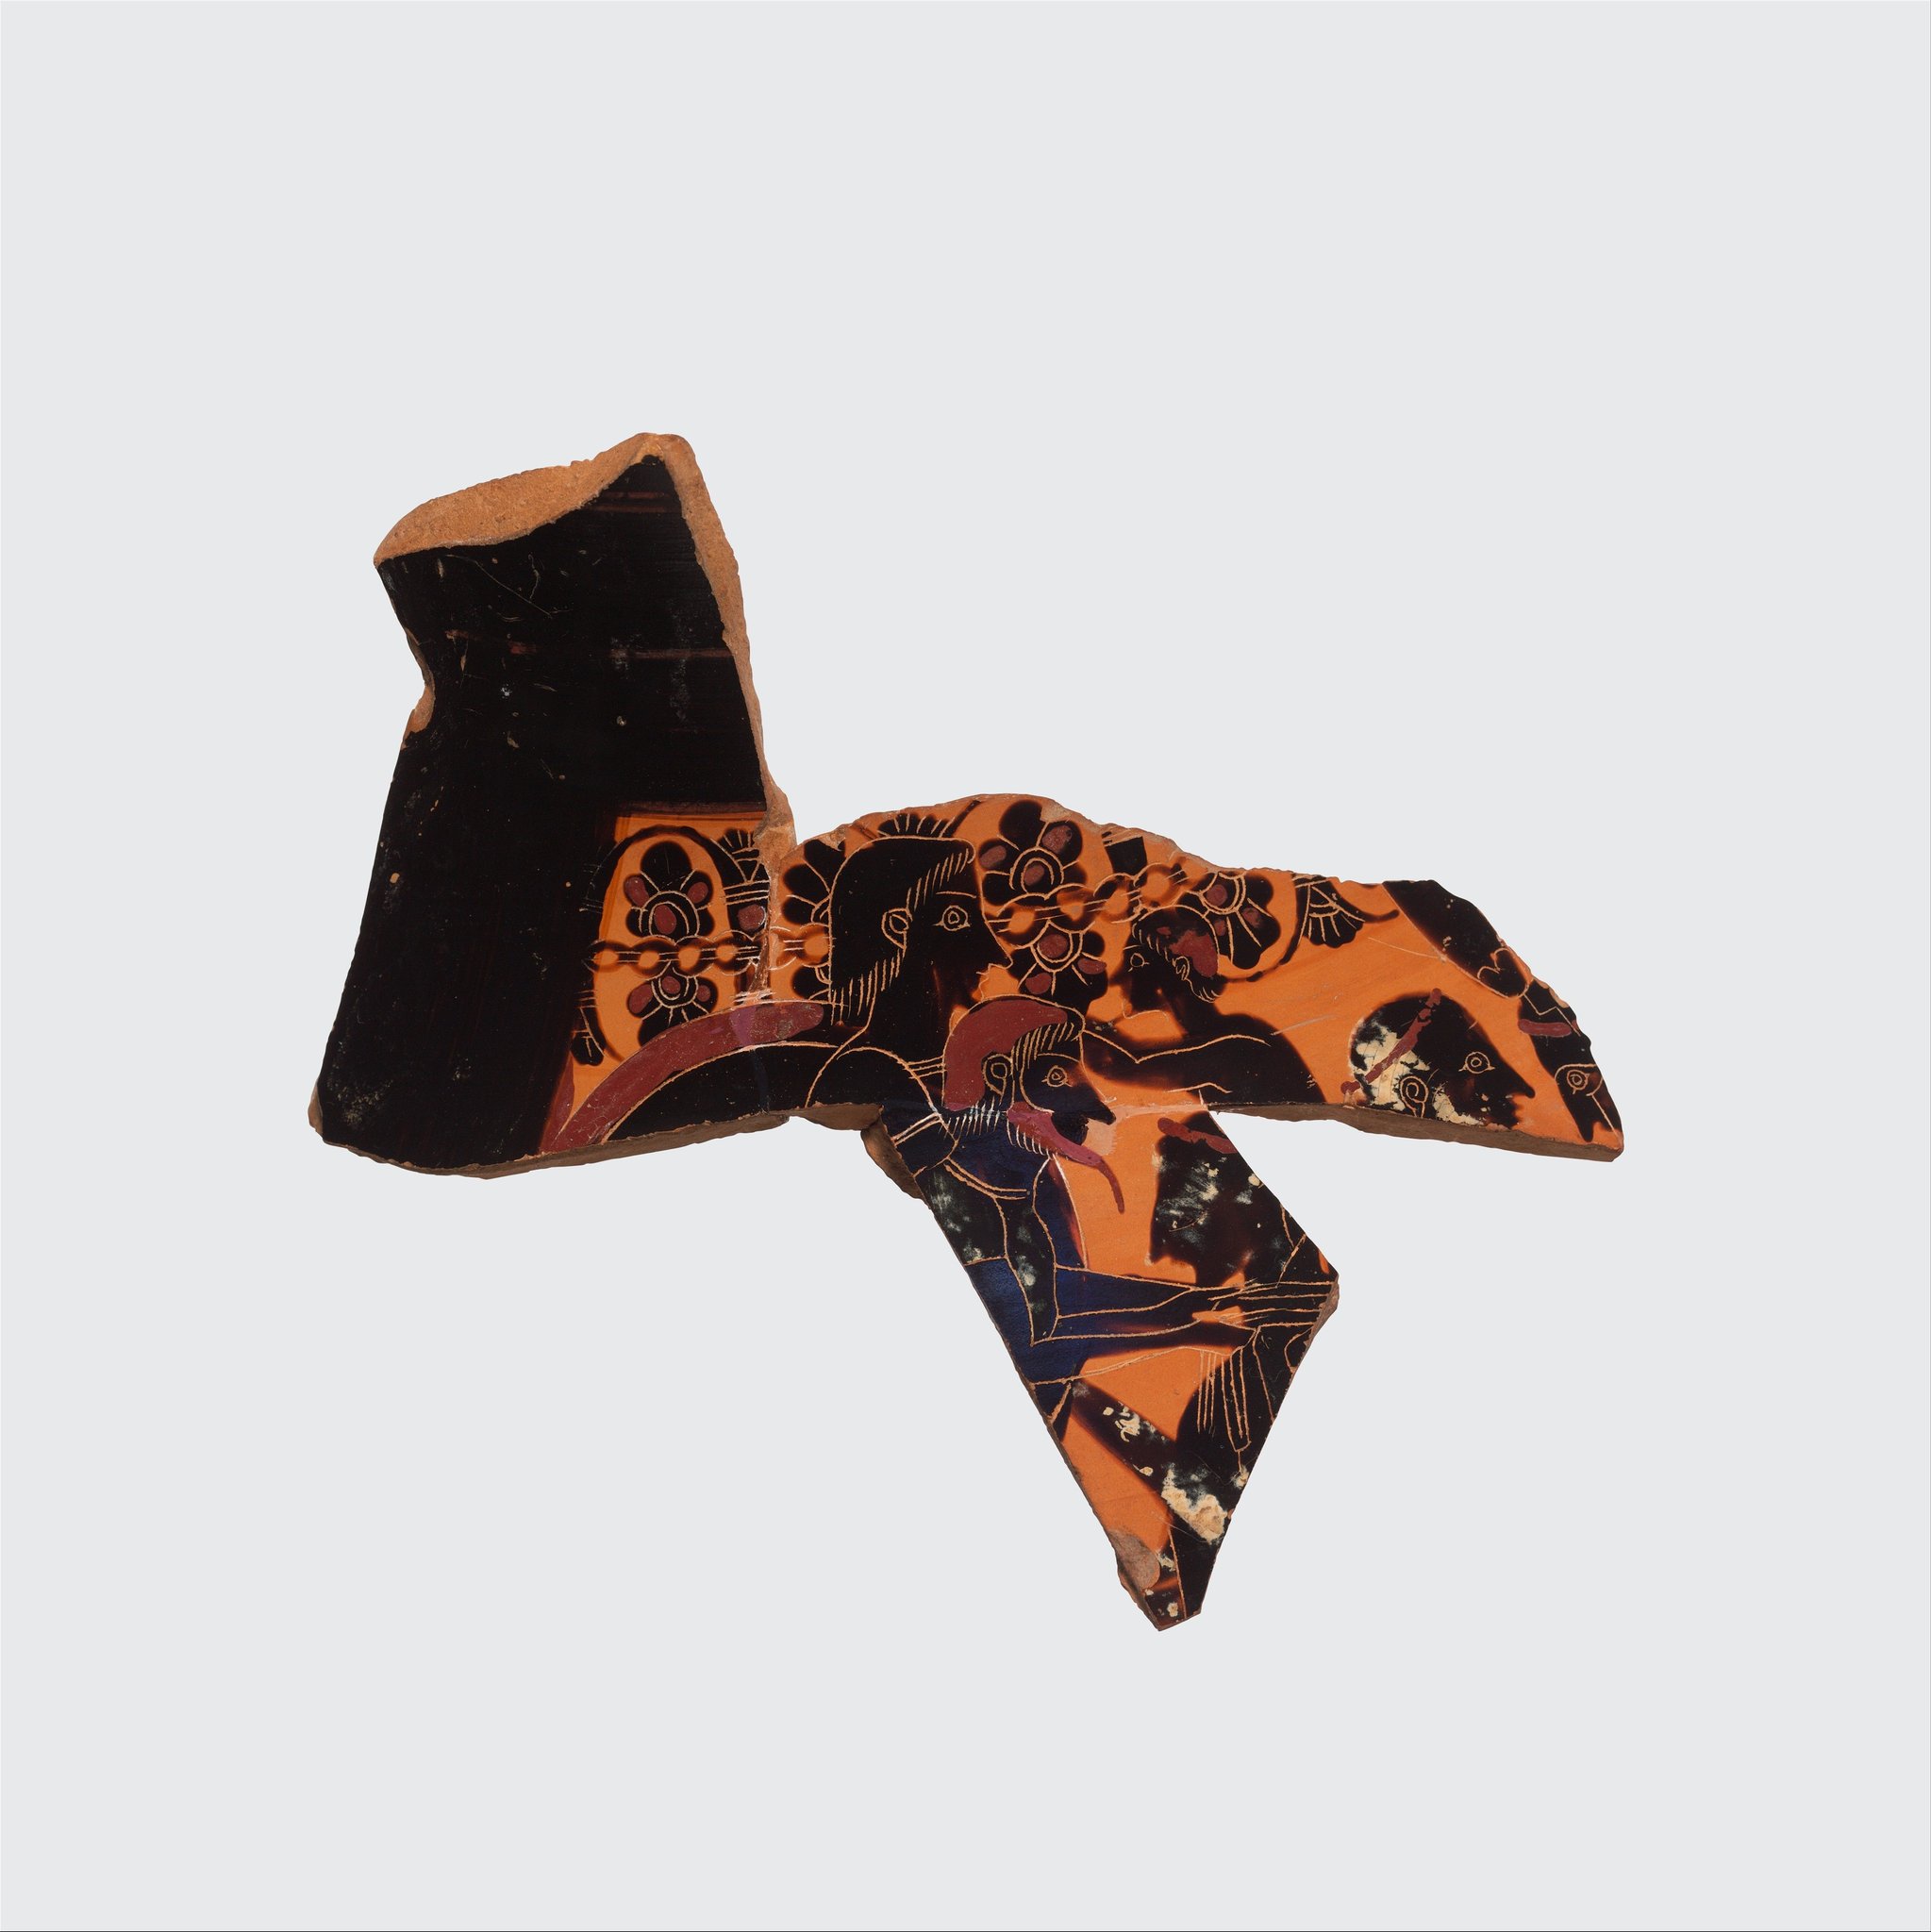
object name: amphora fragment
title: Fragment of a terracotta amphora (jar)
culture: greek, attic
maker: group of london b 174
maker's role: artist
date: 540 BCE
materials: terracotta